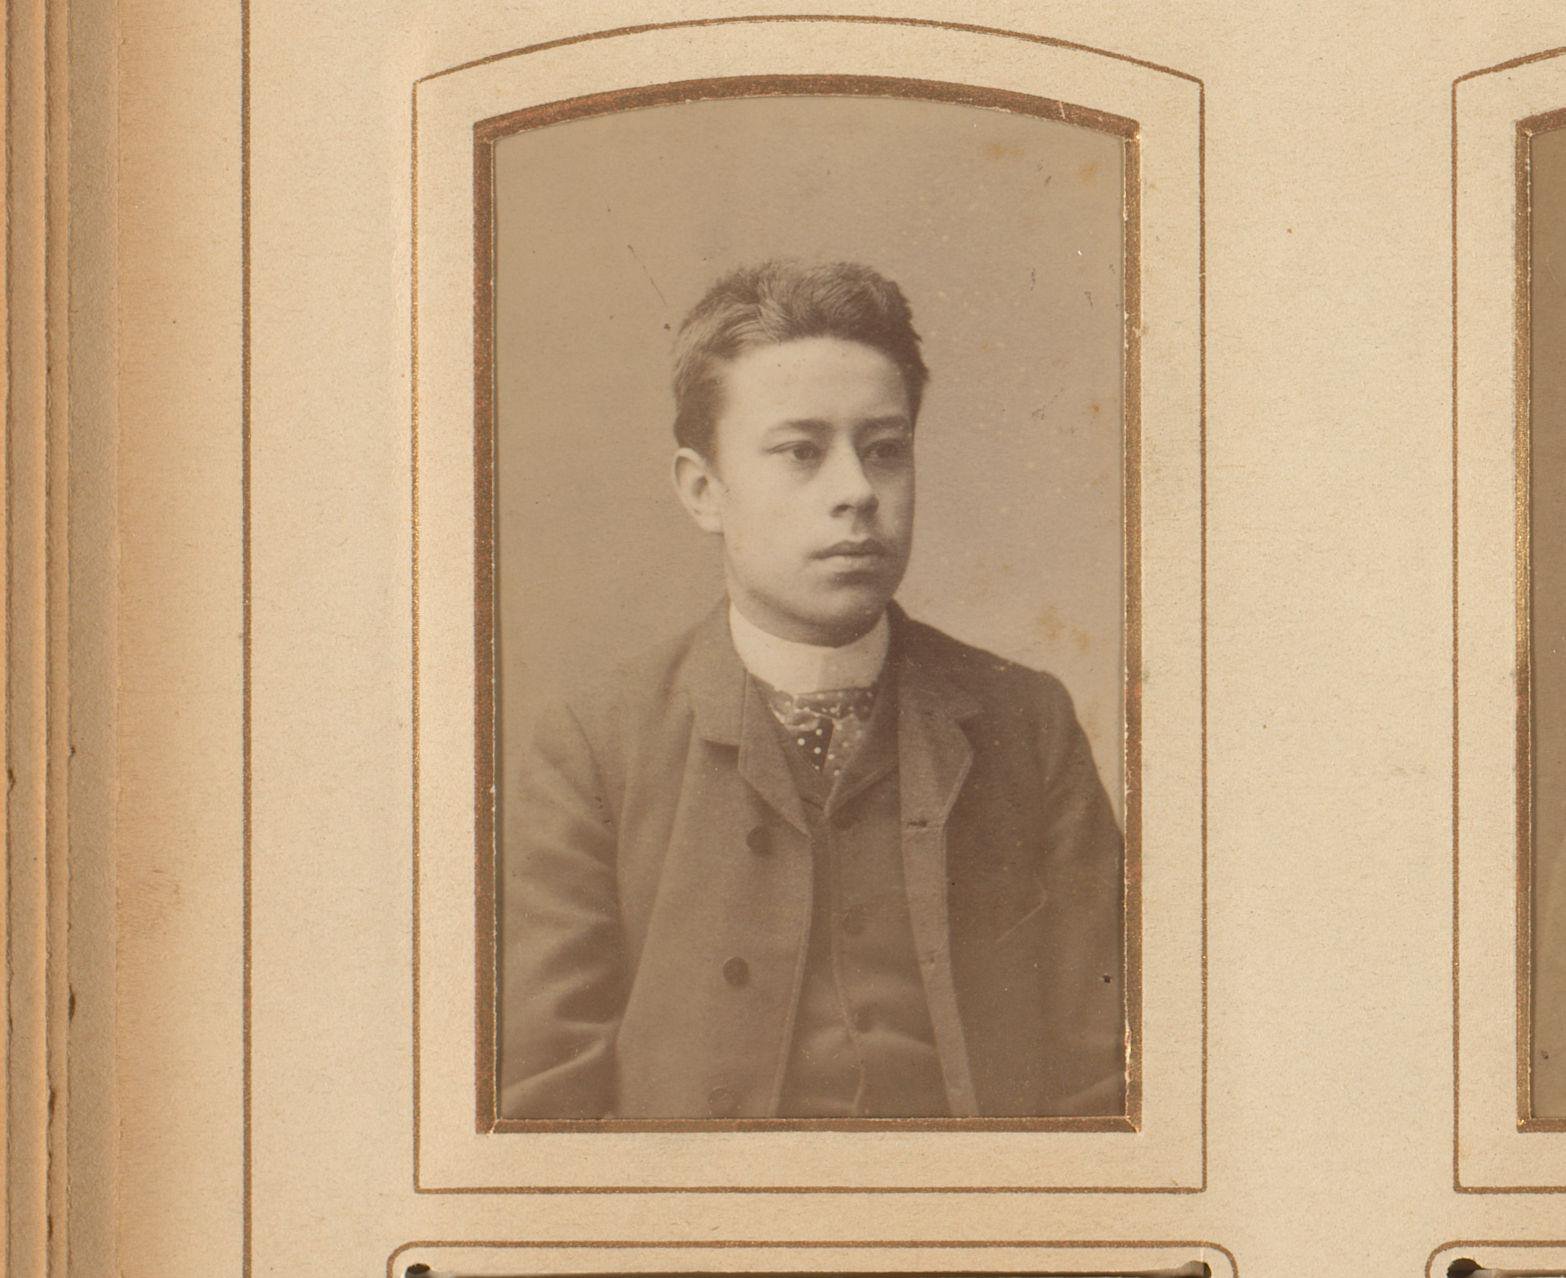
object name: album leaf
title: Portret van een jongen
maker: Anonymous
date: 1870-1900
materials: cardboard, photographic support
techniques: albumen print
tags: boy (child between toddler and youth), historical persons